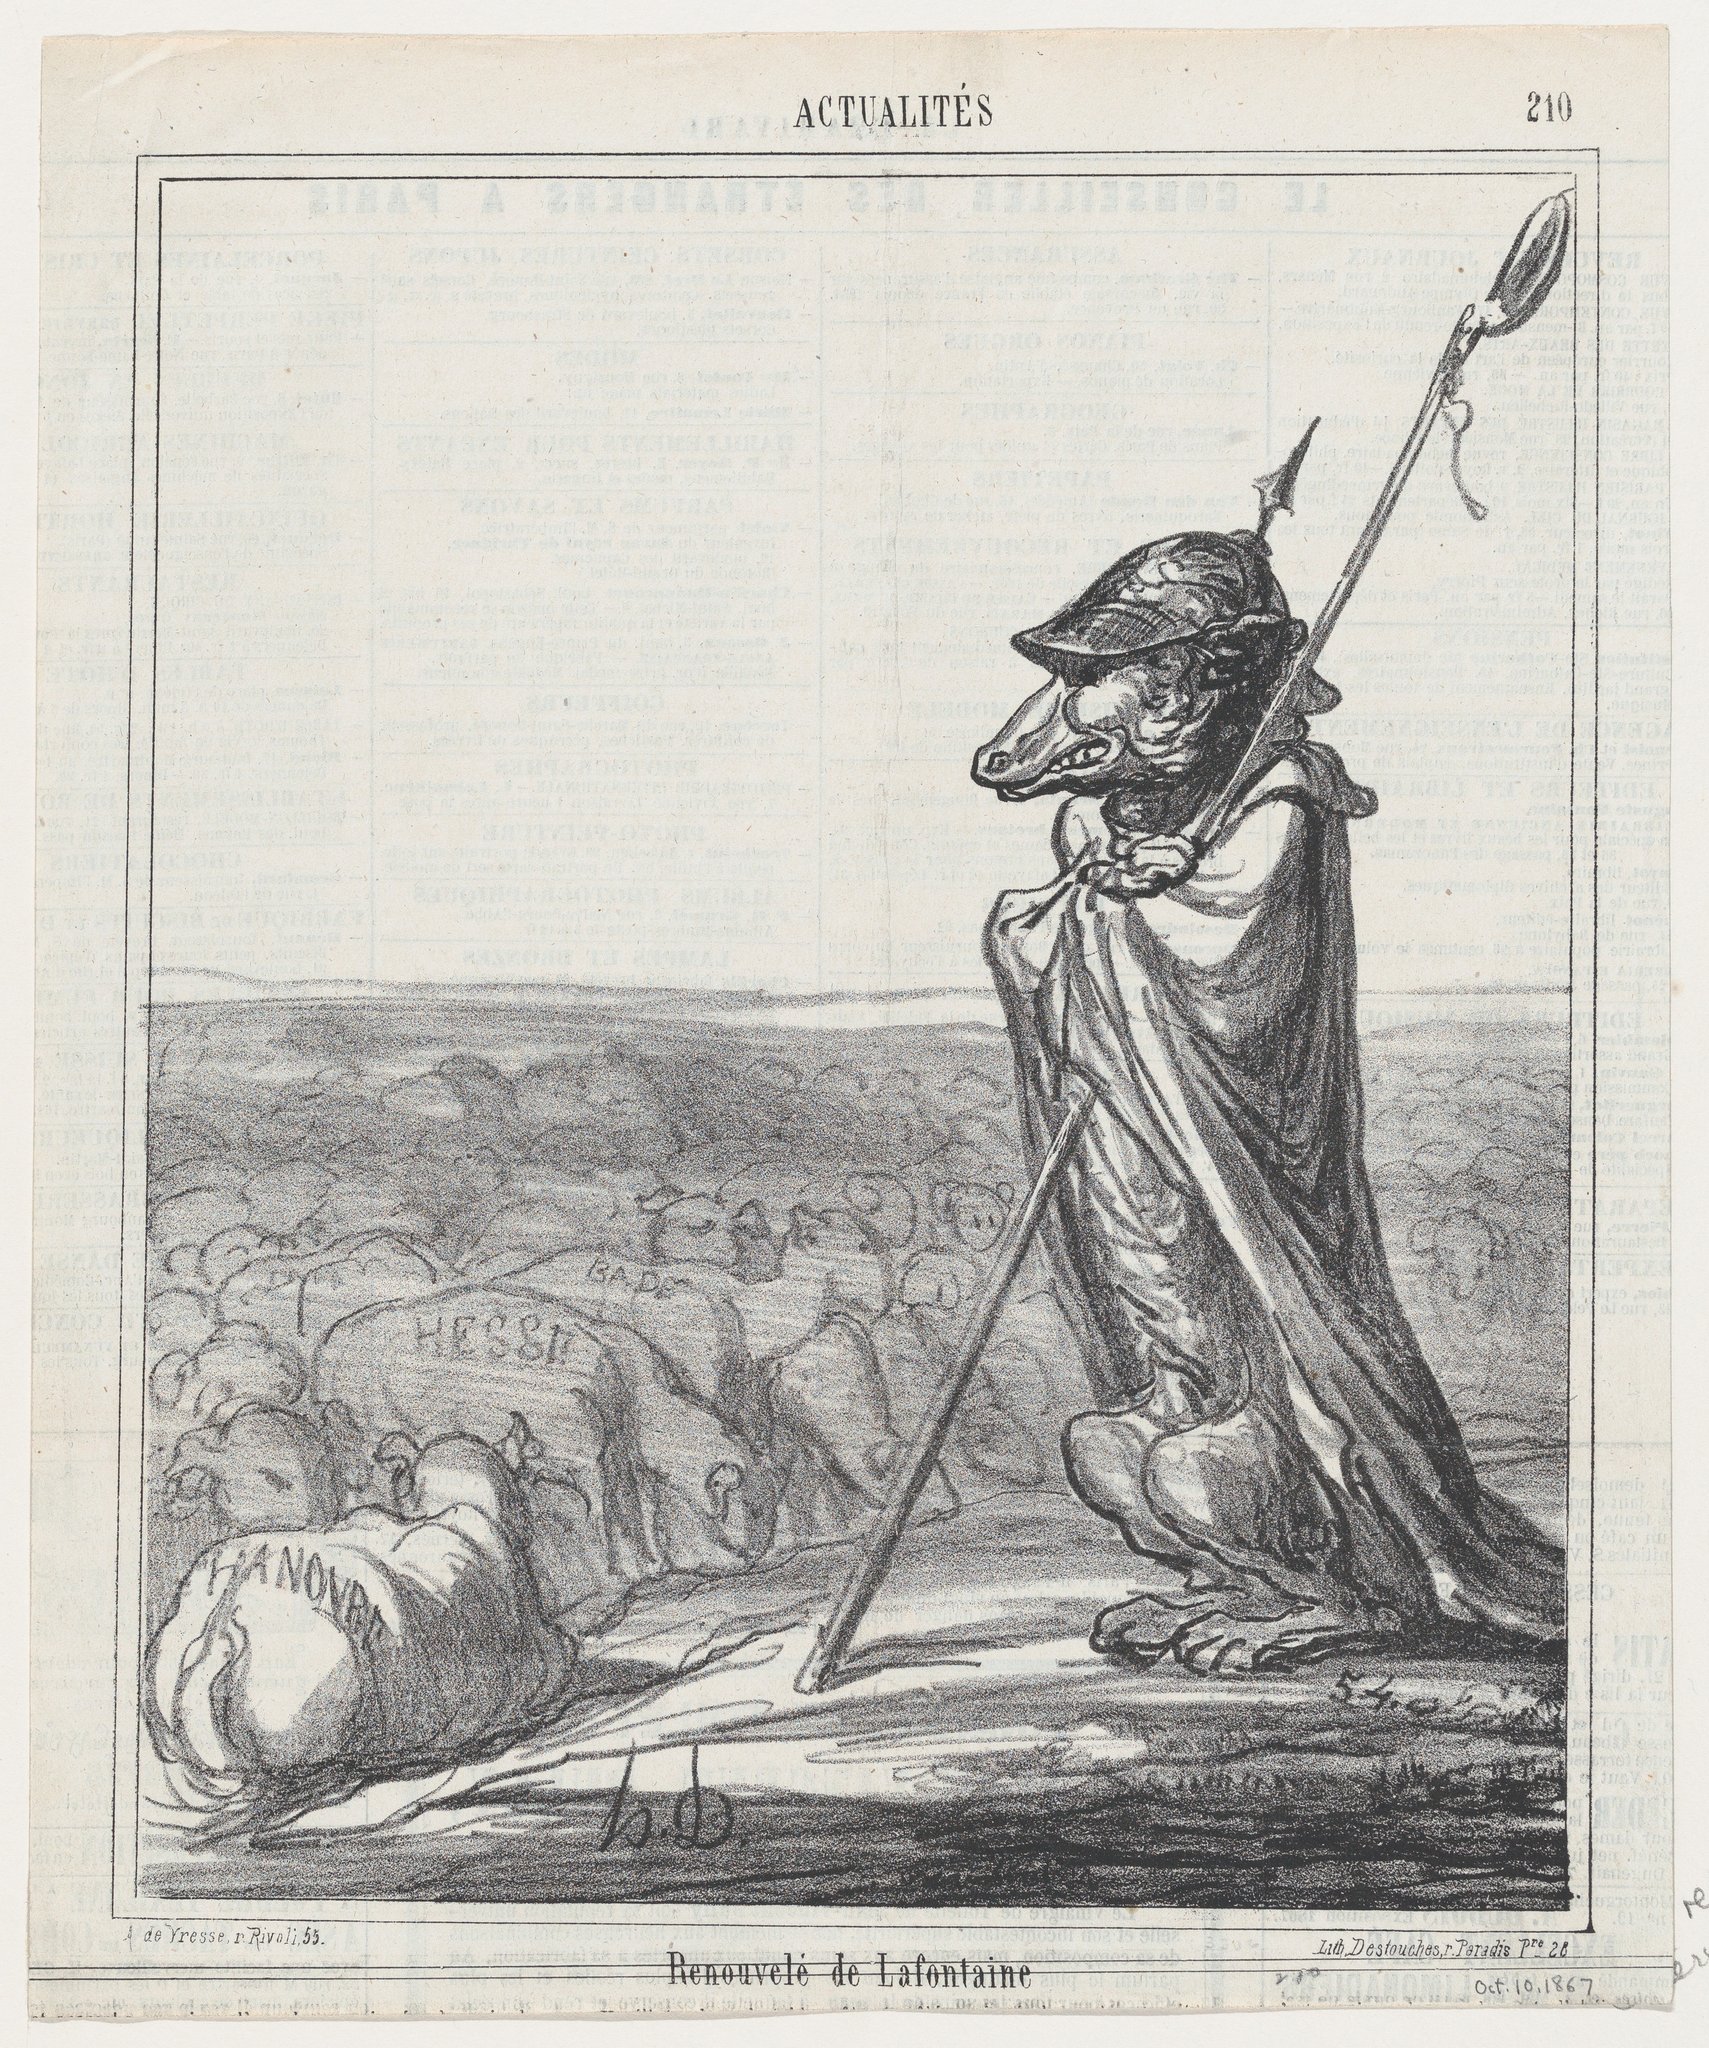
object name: print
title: La Fontaine renewed, from "News of the Day"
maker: honoré daumier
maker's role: artist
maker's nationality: french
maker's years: 1808-1879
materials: paper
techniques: lithograph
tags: satire,sheep